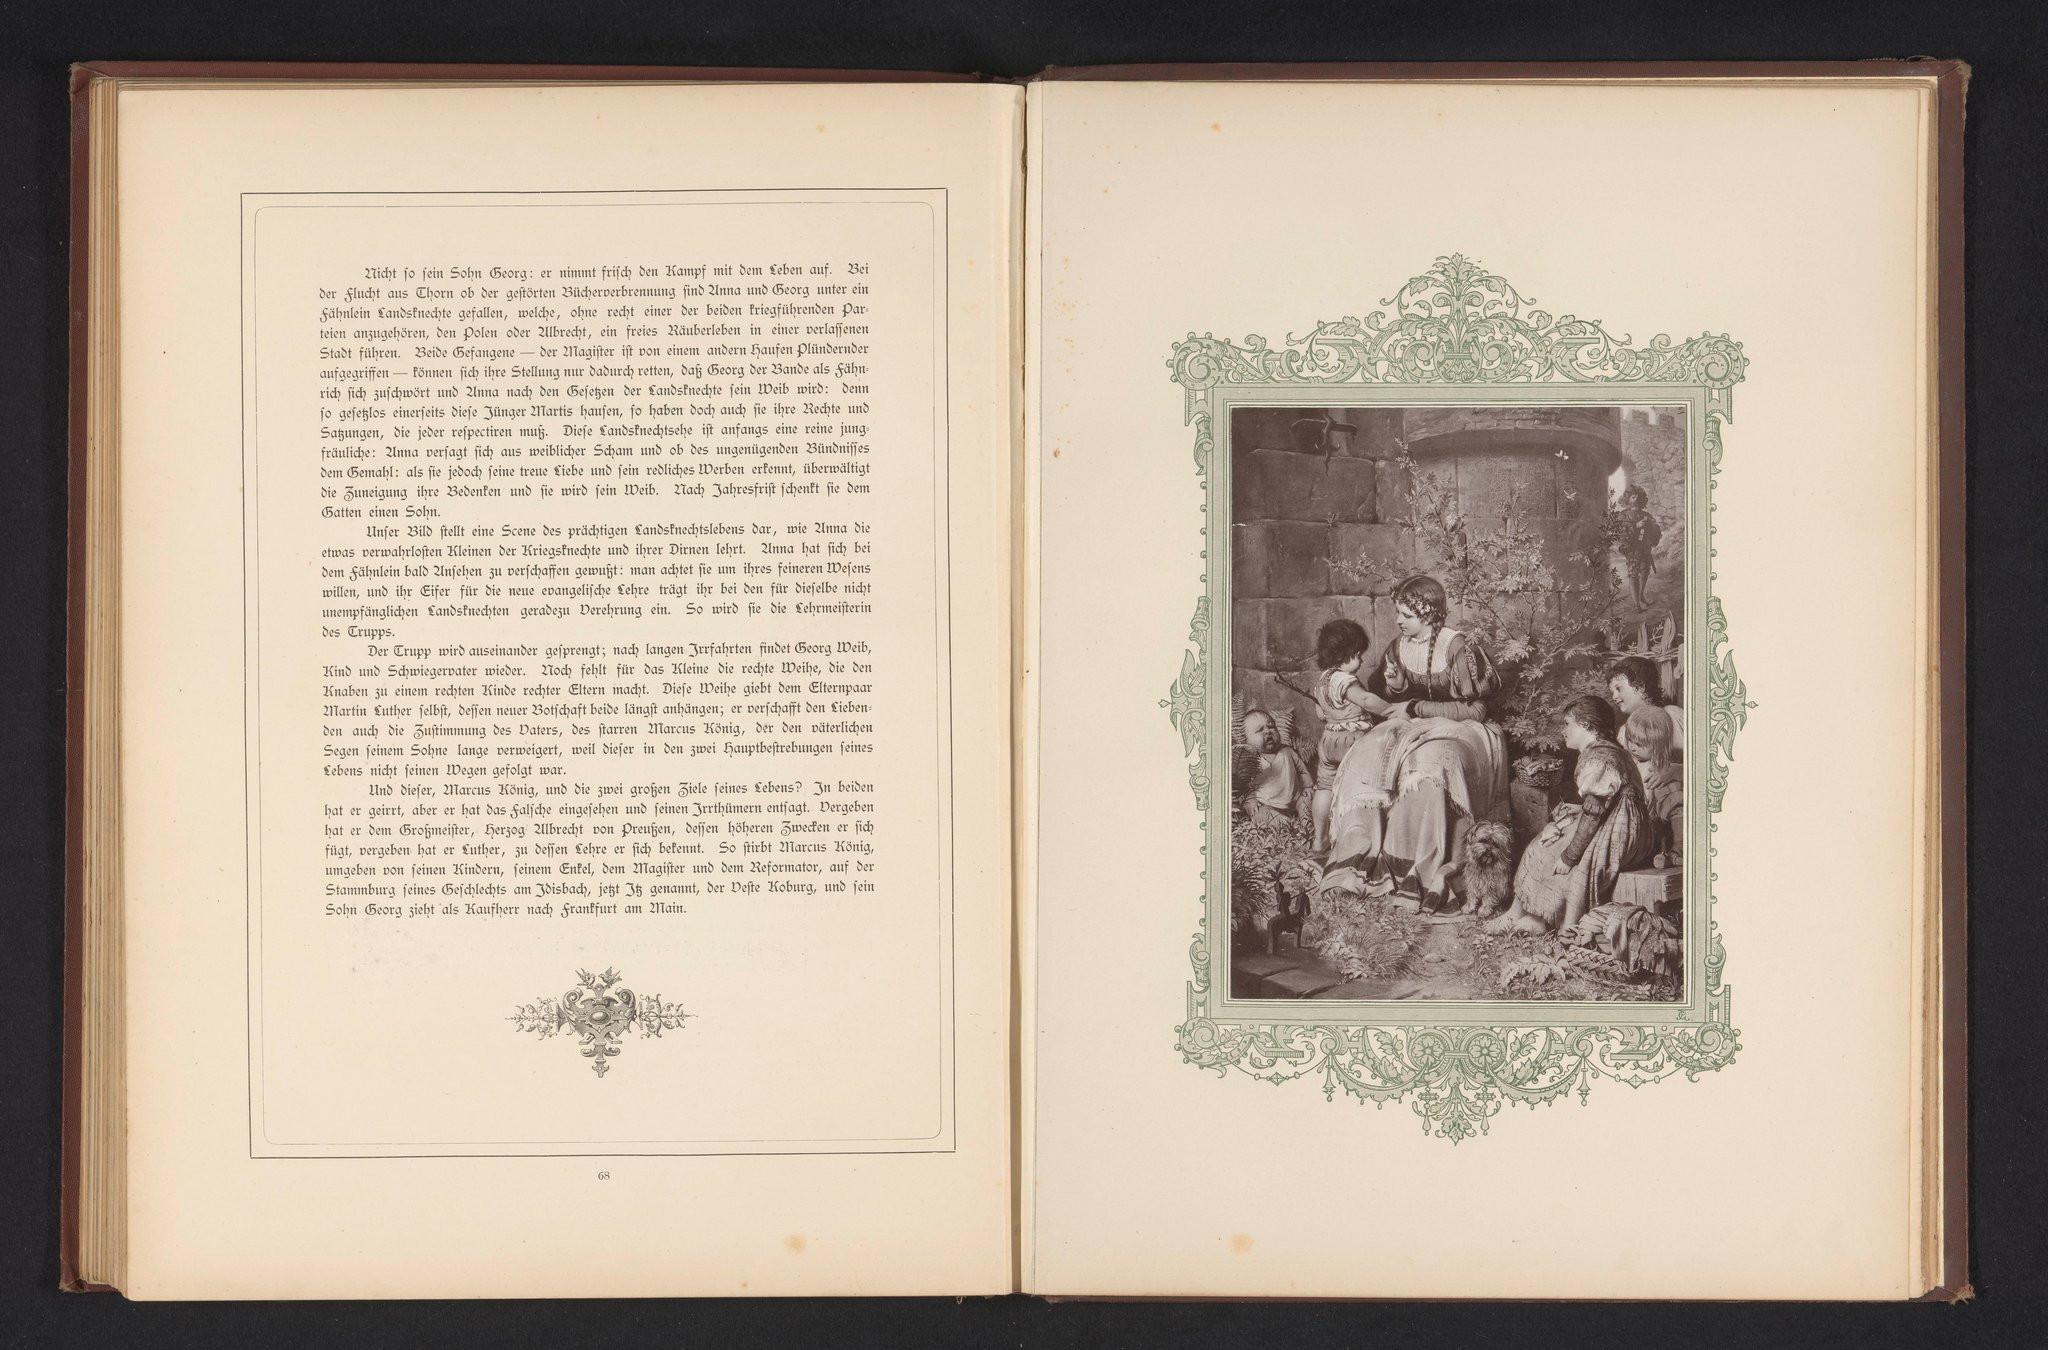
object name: photomechanical print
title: Fotoreproductie van een schilderij voorstellende Anna Fabricius die de kinderen van de huurlingen onderwijst uit Die Ahnen door Gustav Freytag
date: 1877-1882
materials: paper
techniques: photograph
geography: germany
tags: child teaching teacher, parents, or other adults